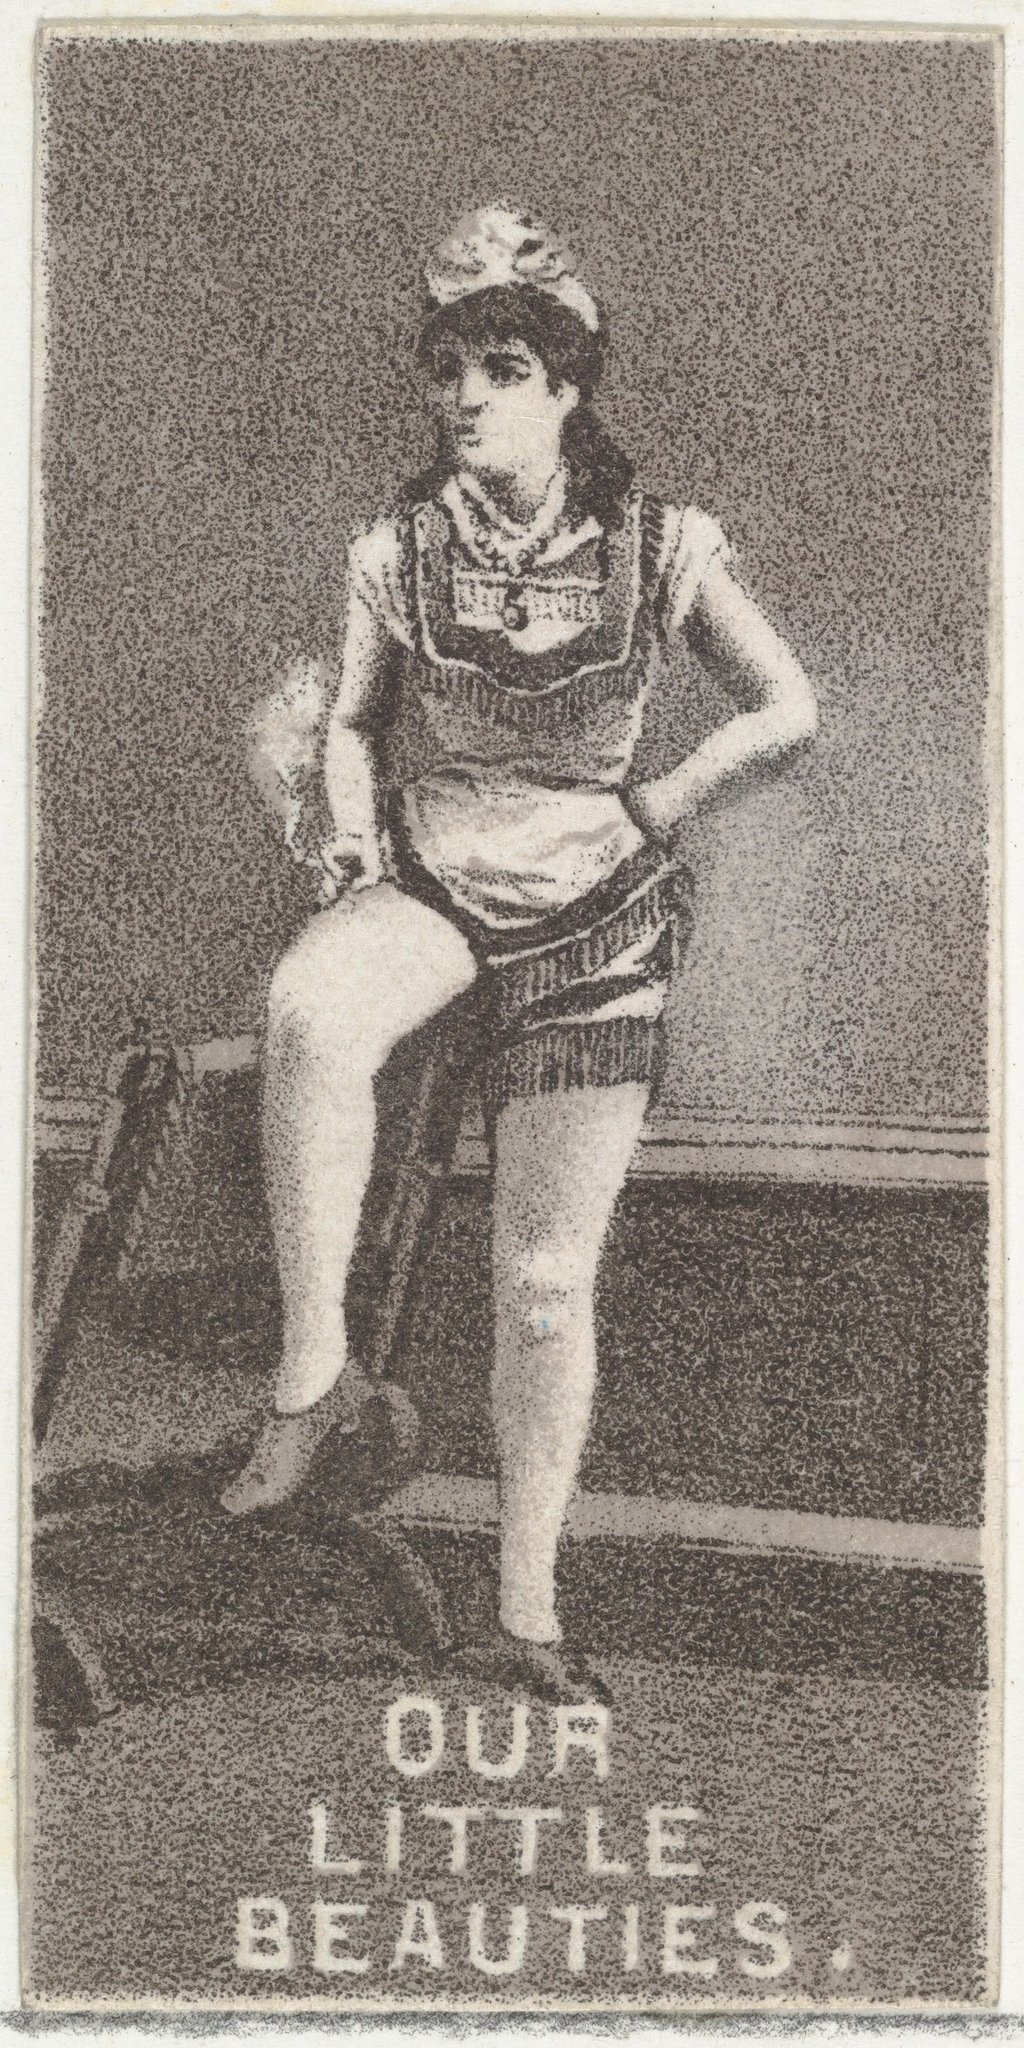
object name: print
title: From the Actresses series (N57) promoting Our Little Beauties Cigarettes for Allen & Ginter brand tobacco products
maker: allen & ginter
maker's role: publisher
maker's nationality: american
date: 1890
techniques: photolithograph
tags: portraits,women,actresses